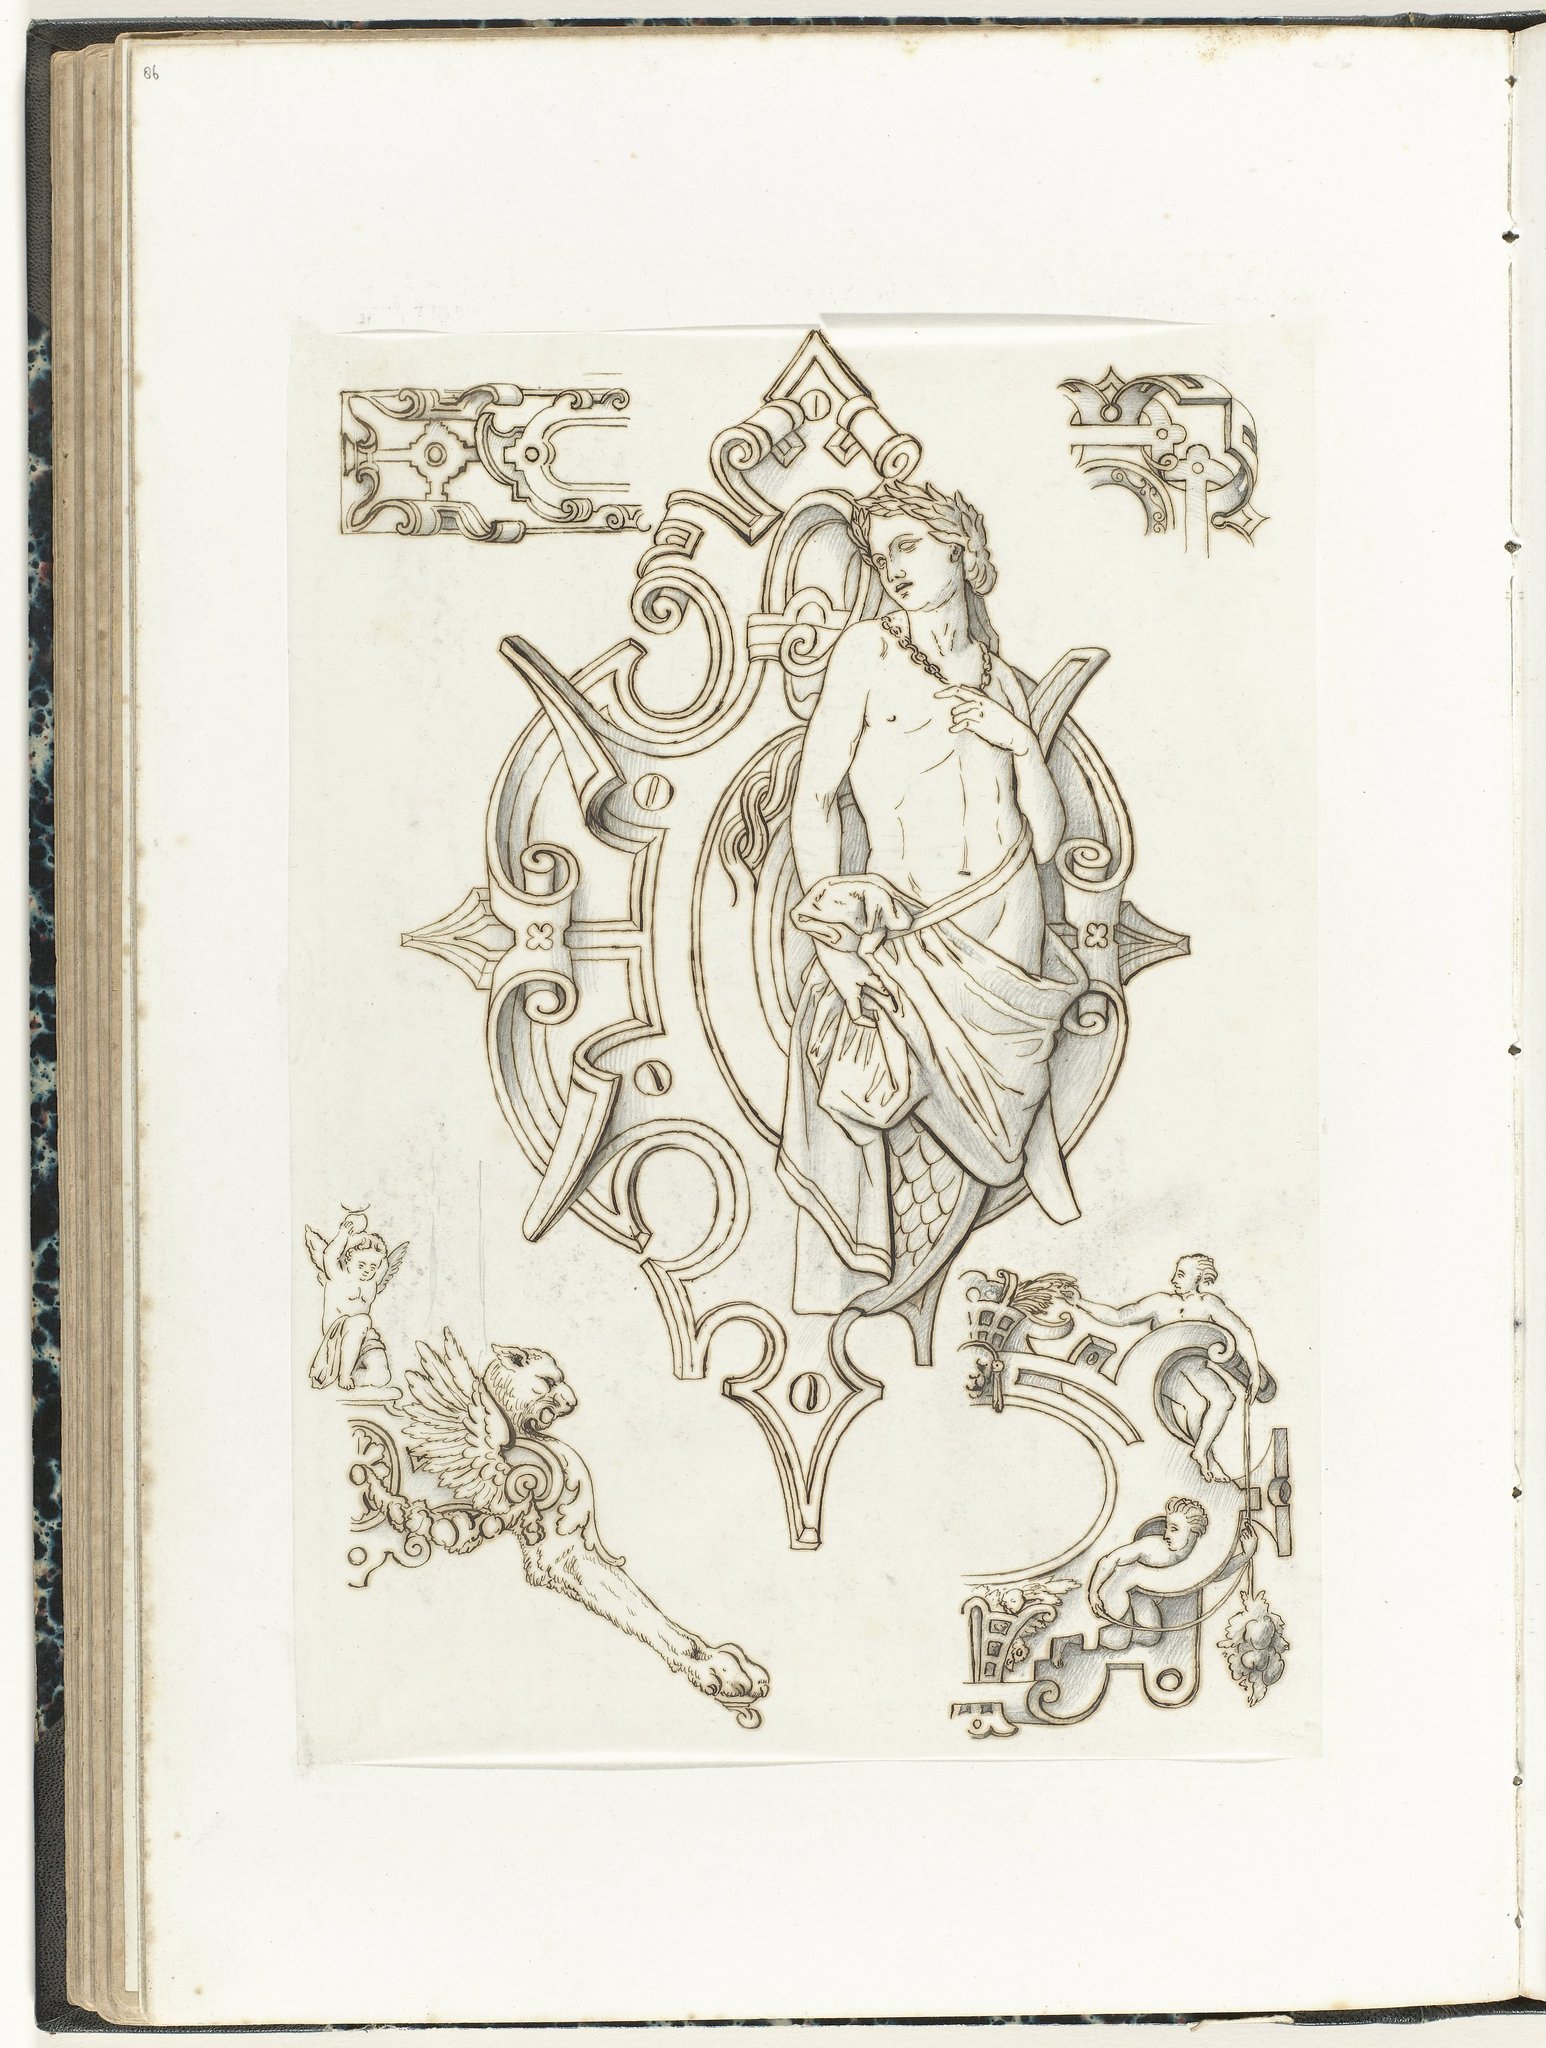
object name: drawing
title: Vijf cartouches van beslagwerk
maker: Anonymous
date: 1866-1900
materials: paper, pencil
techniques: drawing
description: In het midden een cartouche met het bovenlichaam van een man die een lauwerkrans en een ketting draagt. De cartouches in de hoeken zijn voor de helft afgebeeld.